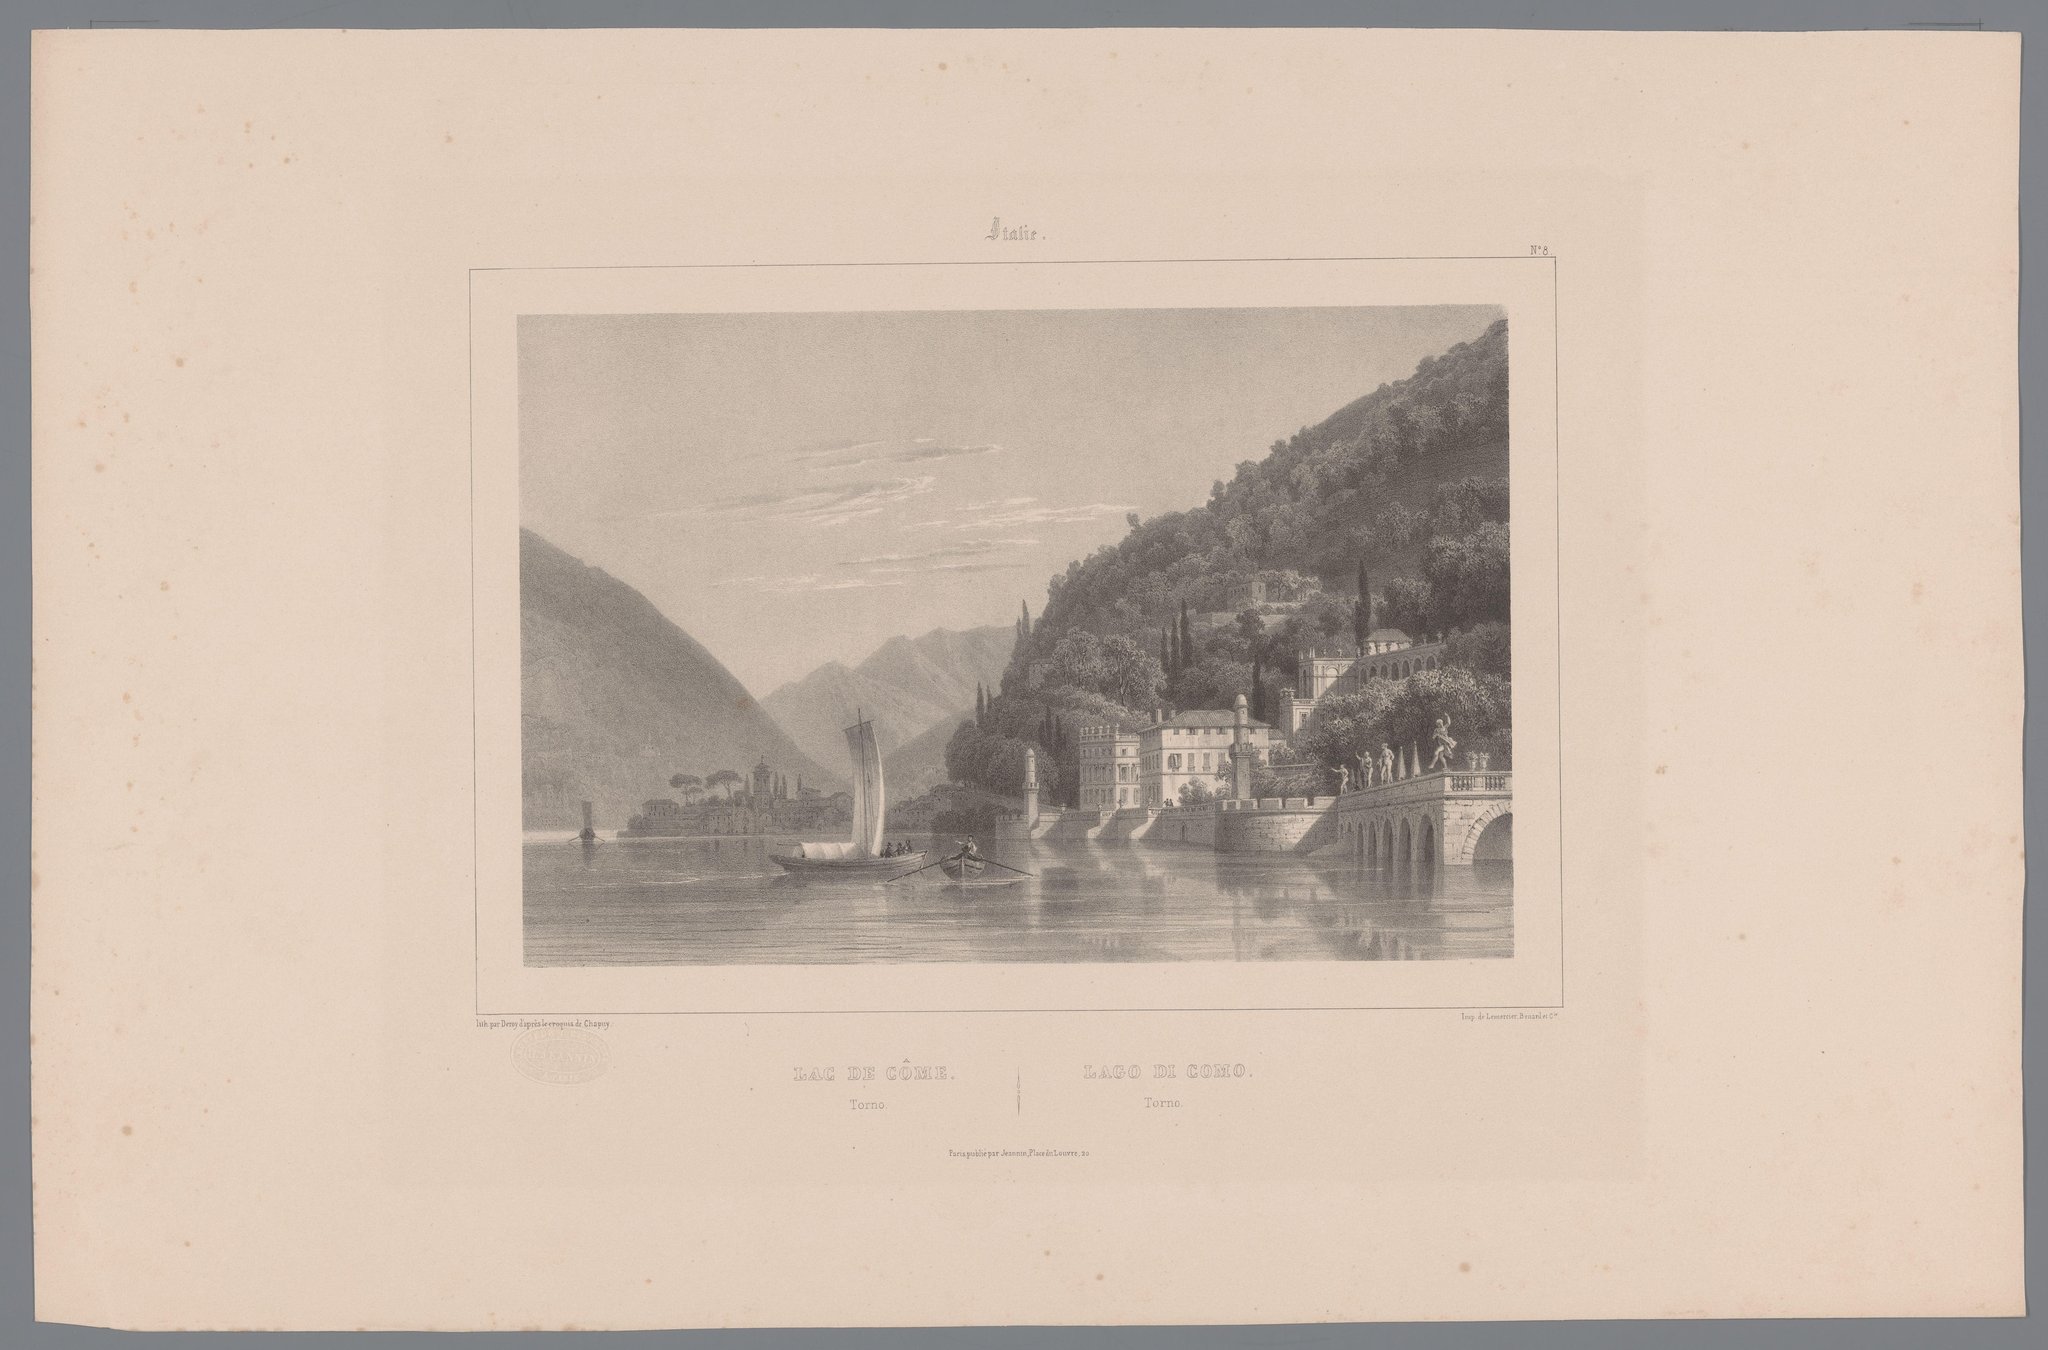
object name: print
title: Gezichten rond het Comomeer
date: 1838-1841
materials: paper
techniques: lithograph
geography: paris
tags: prospect of village, silhouette of village, sailing-ship, sailing-boat, lake (+ landscape with figures, staffage)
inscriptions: collector's mark: Lugt 2228a, check stamp: Lugt 1397c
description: Prent maakt deel uit van een omslag met zes prenten.